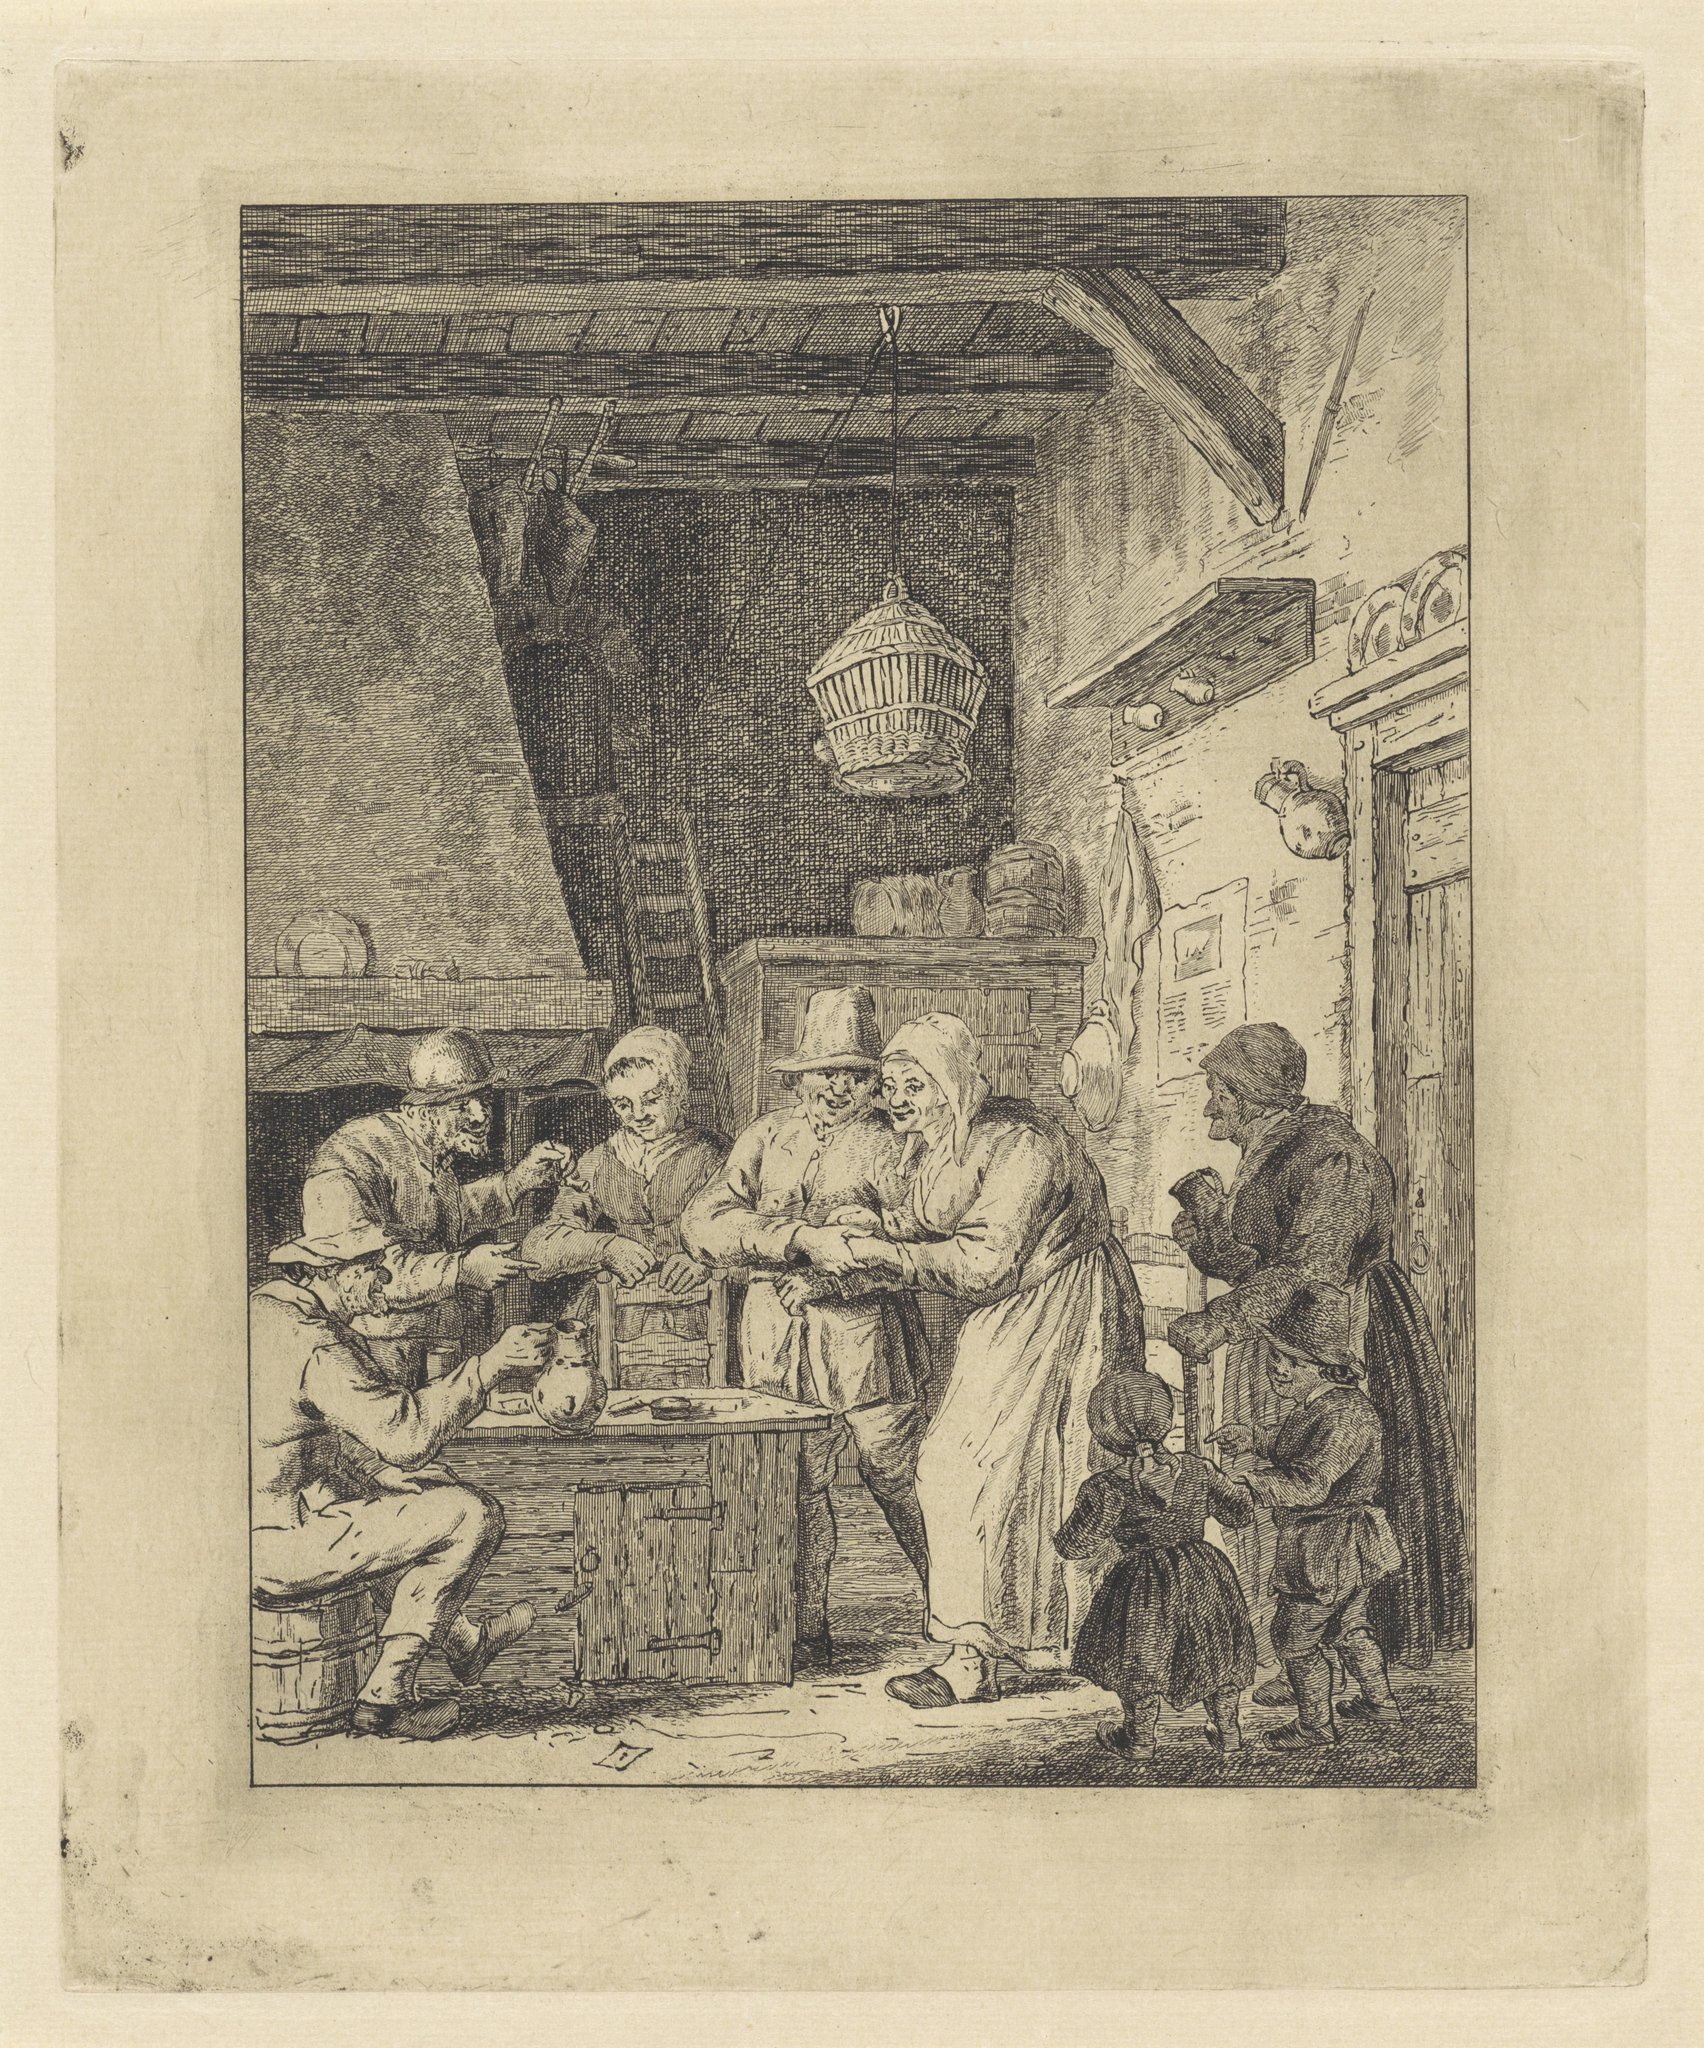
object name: print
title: Gezelschap in een interieur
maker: nicolaas van der worm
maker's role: draughtsman, print maker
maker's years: 1757-1828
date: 1772-1828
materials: paper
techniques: etching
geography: leiden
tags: family group, especially parents with their child(ren), communal rooms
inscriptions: collector's mark: Lugt 240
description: Een groep mensen van verschillende leeftijden heeft zich rond een tafel in een eenvoudig interieur verzameld. Enkelen van hen houden een kruik of een pijp vast.